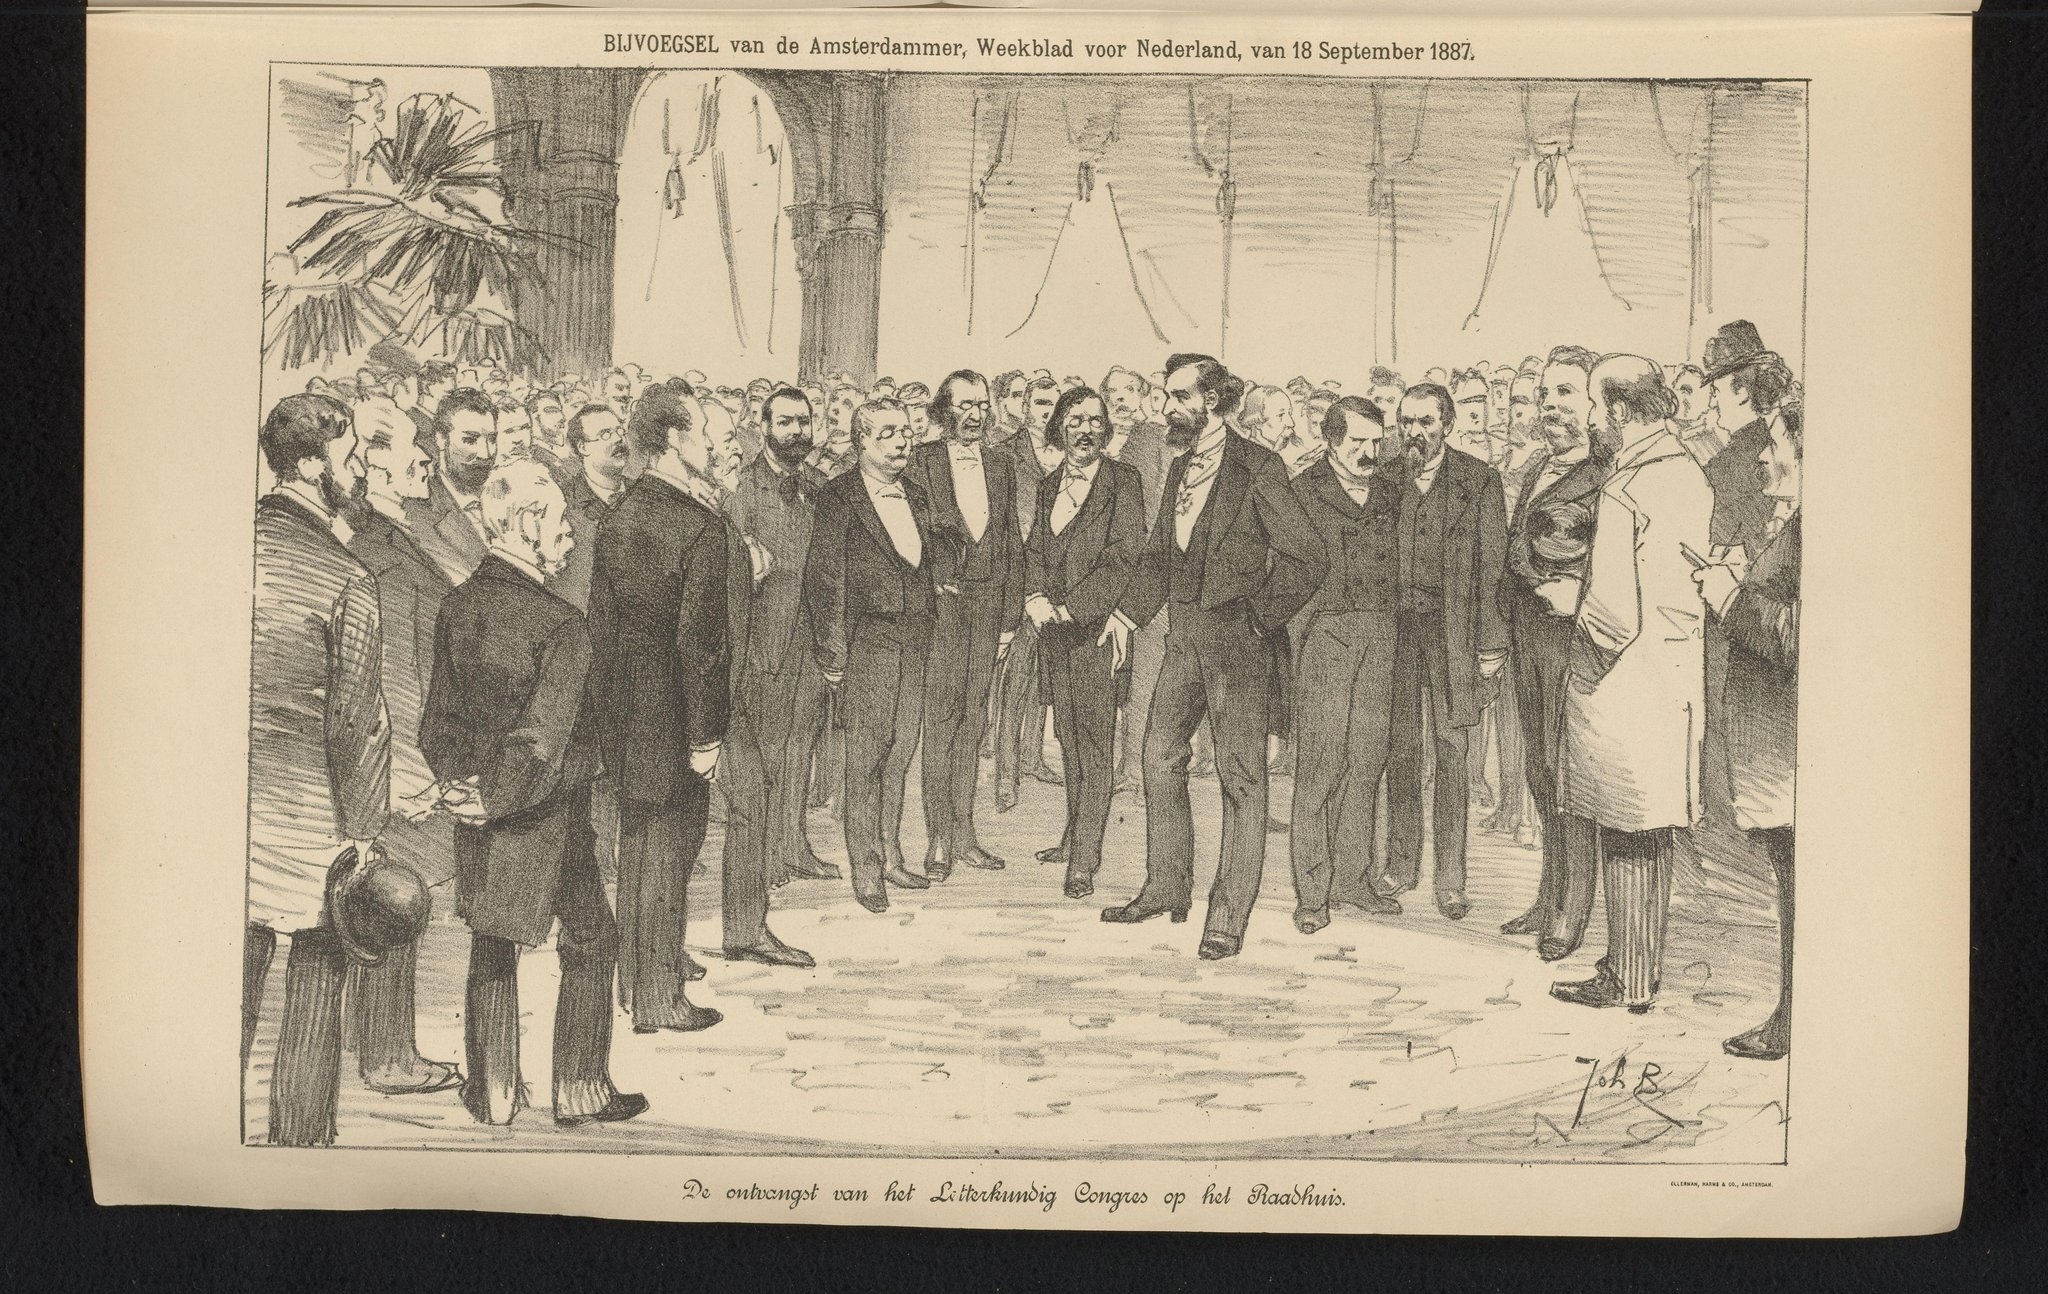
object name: print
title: De ontvangst van het Letterkundig Congres op het Raadhuis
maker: johan braakensiek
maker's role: draughtsman, print maker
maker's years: 1858-1940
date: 1887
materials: paper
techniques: lithograph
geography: amsterdam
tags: mayor, gijsbert van tienhoven, mayor, burgomaster, historical persons, amsterdam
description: Deelnemers van het twintigste Nederlandsch Taal- en Letterkundig Congres te Amsterdam, 15-17 september 1887, worden op het raadhuis ontvangen door burgemeester Gijsbert van Tienhoven.